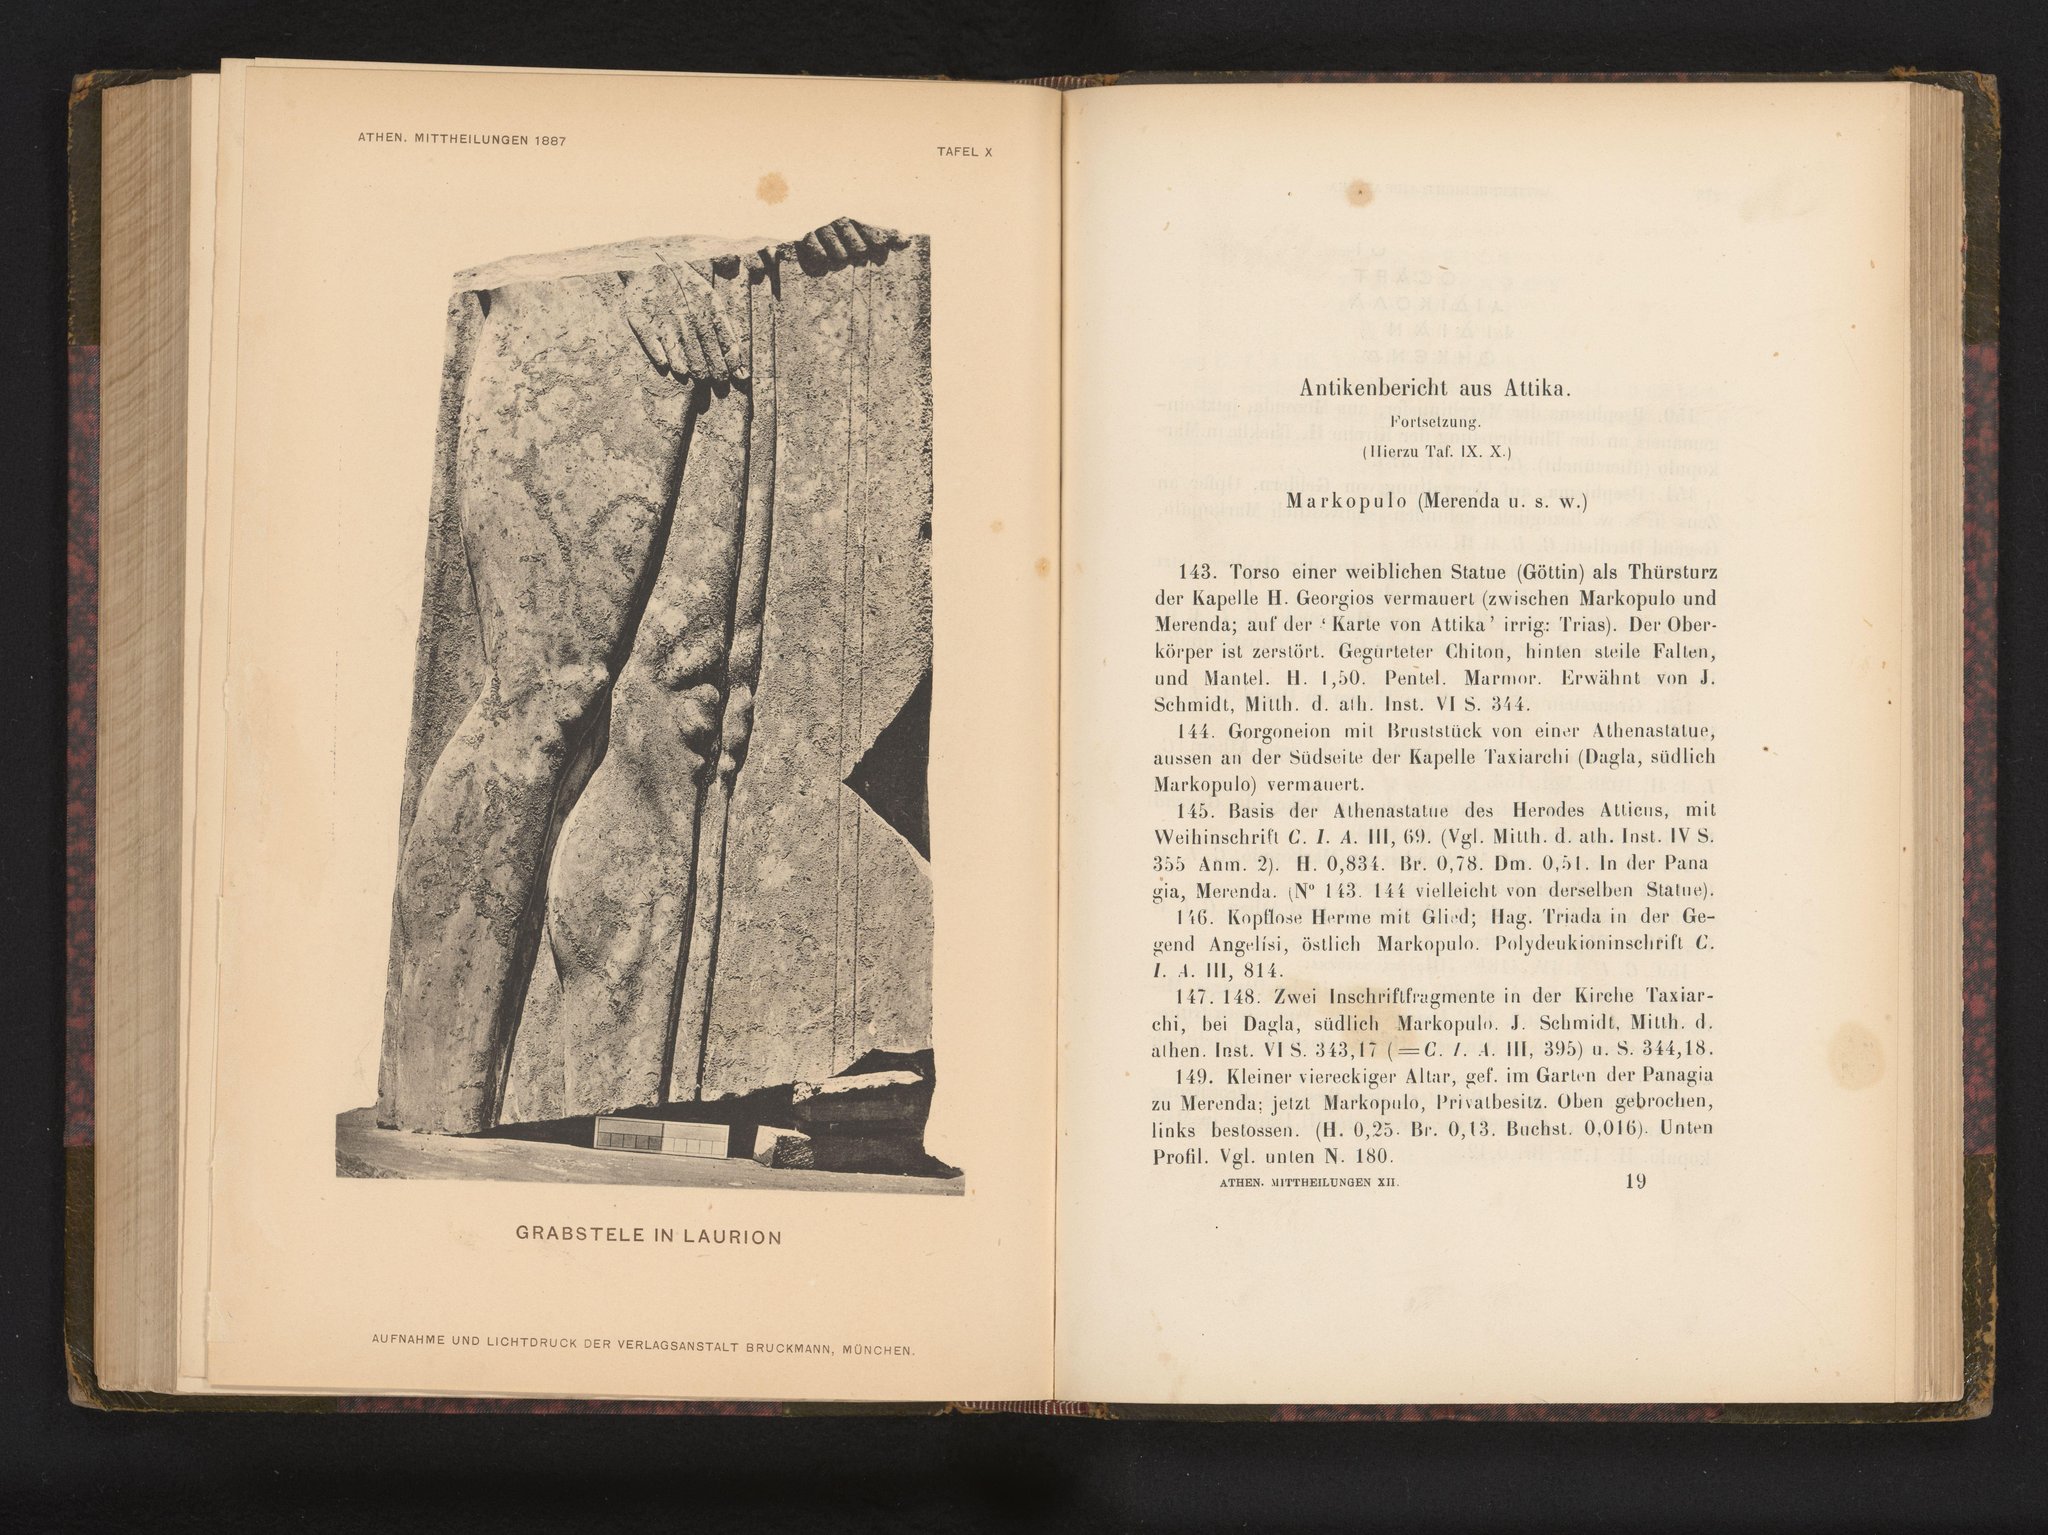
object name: page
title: Grafstele uit Laurion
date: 1881-1886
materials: paper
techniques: photograph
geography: munich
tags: upright gravestone, stone ~ building material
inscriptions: inscription: ‘Athen Mittheilungen 1887 Tafel X’